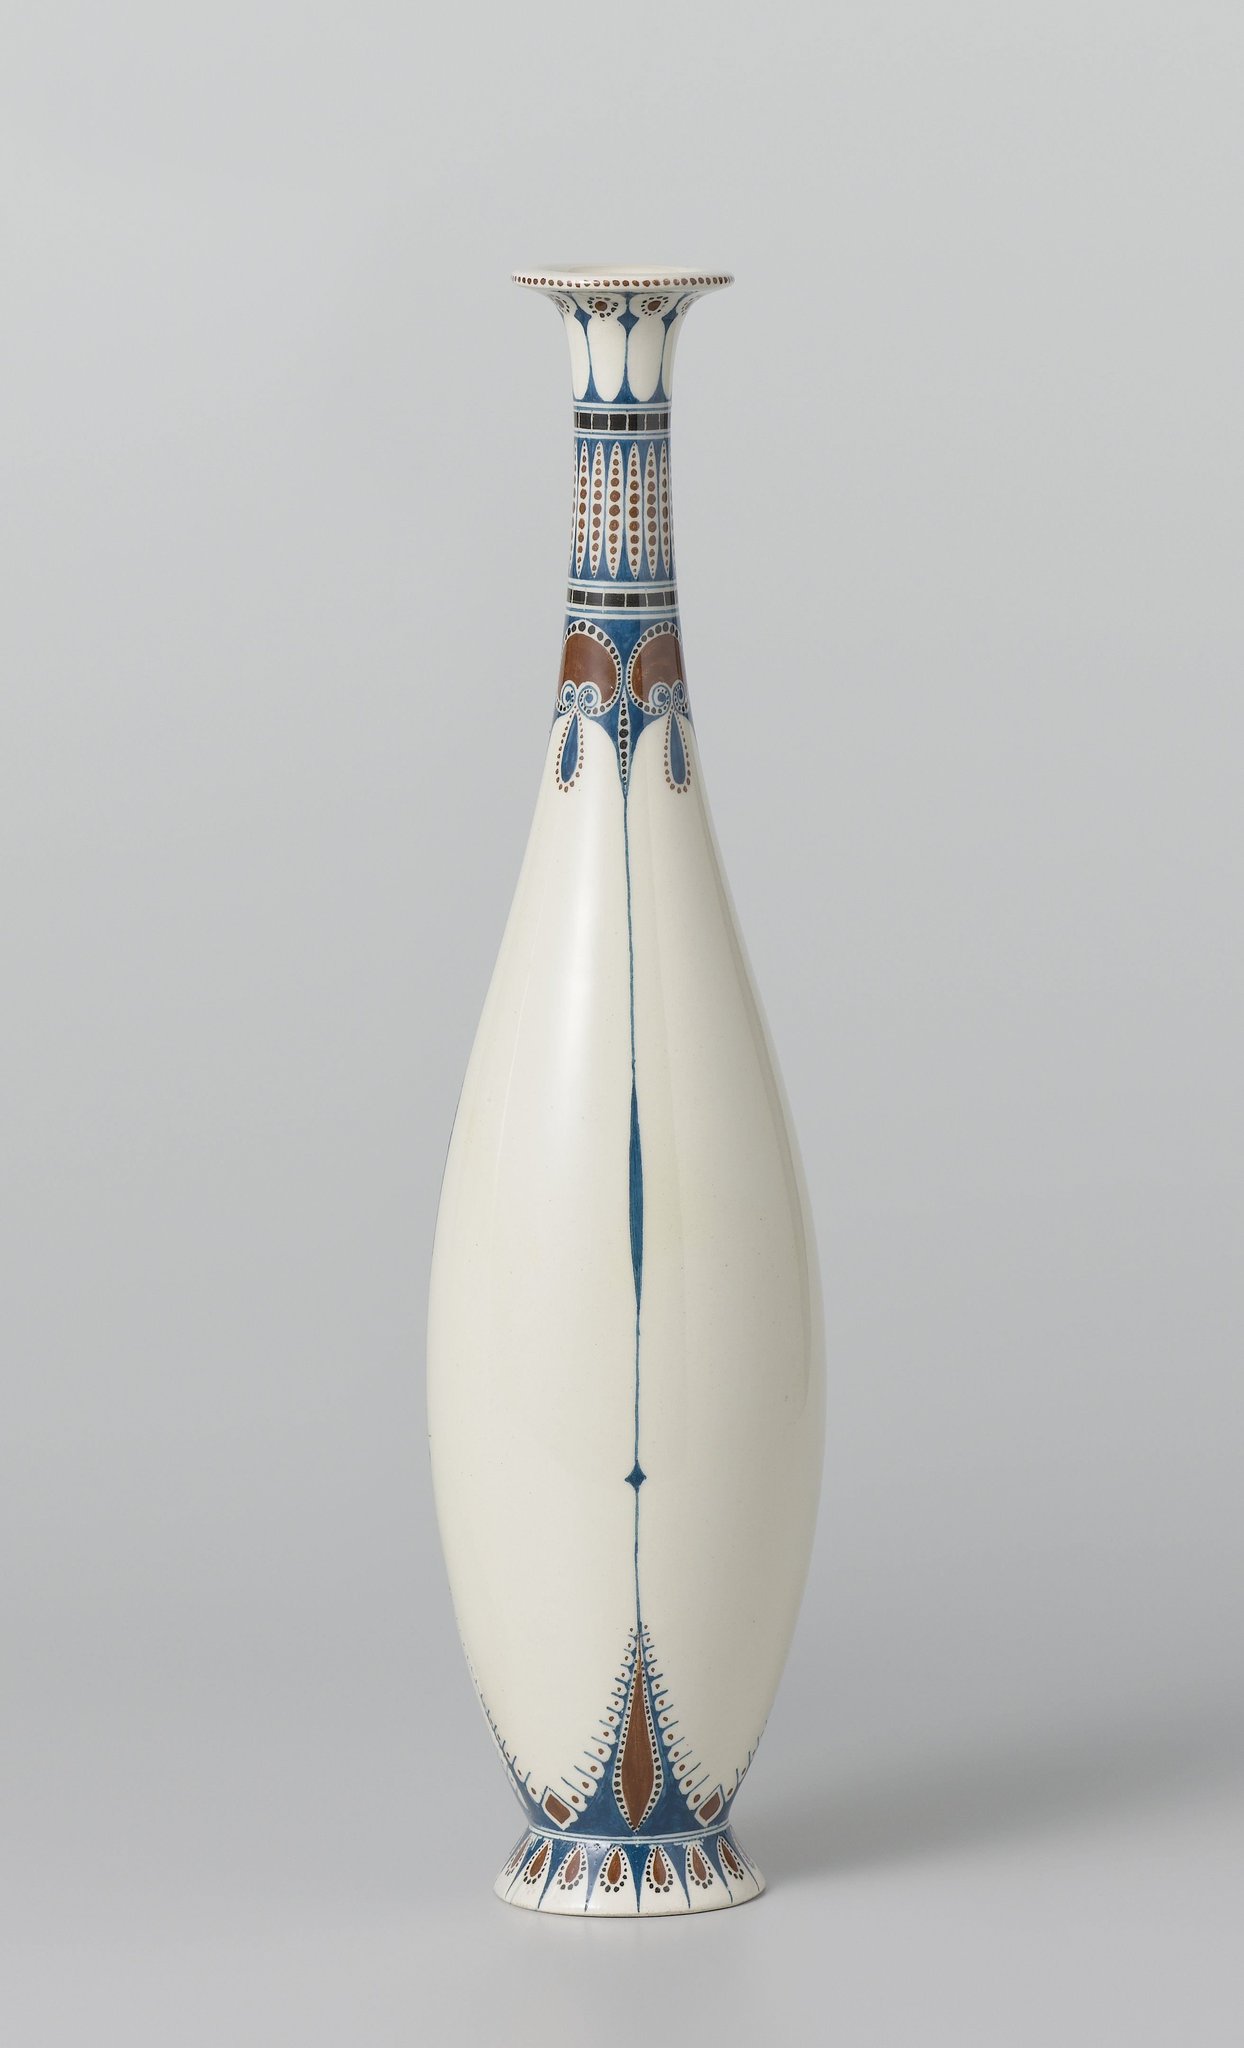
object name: vase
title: Vaas met decor van gestileerde palmetten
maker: chris van der hoef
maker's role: ceramicist, draughtsman, sculptor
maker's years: 1875-1933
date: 1910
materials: earthenware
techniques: painted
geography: oegstgeest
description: Vaas, deel van een paar, van aardewerk, slank peervormig, beschilderd in blauw, bruin en zwart met gestileerde palmetten en andere ornamenten. Gemerkt: AMPHORA HOLLAND ontw CJvd HOEF 210-1; ingegrift 210.